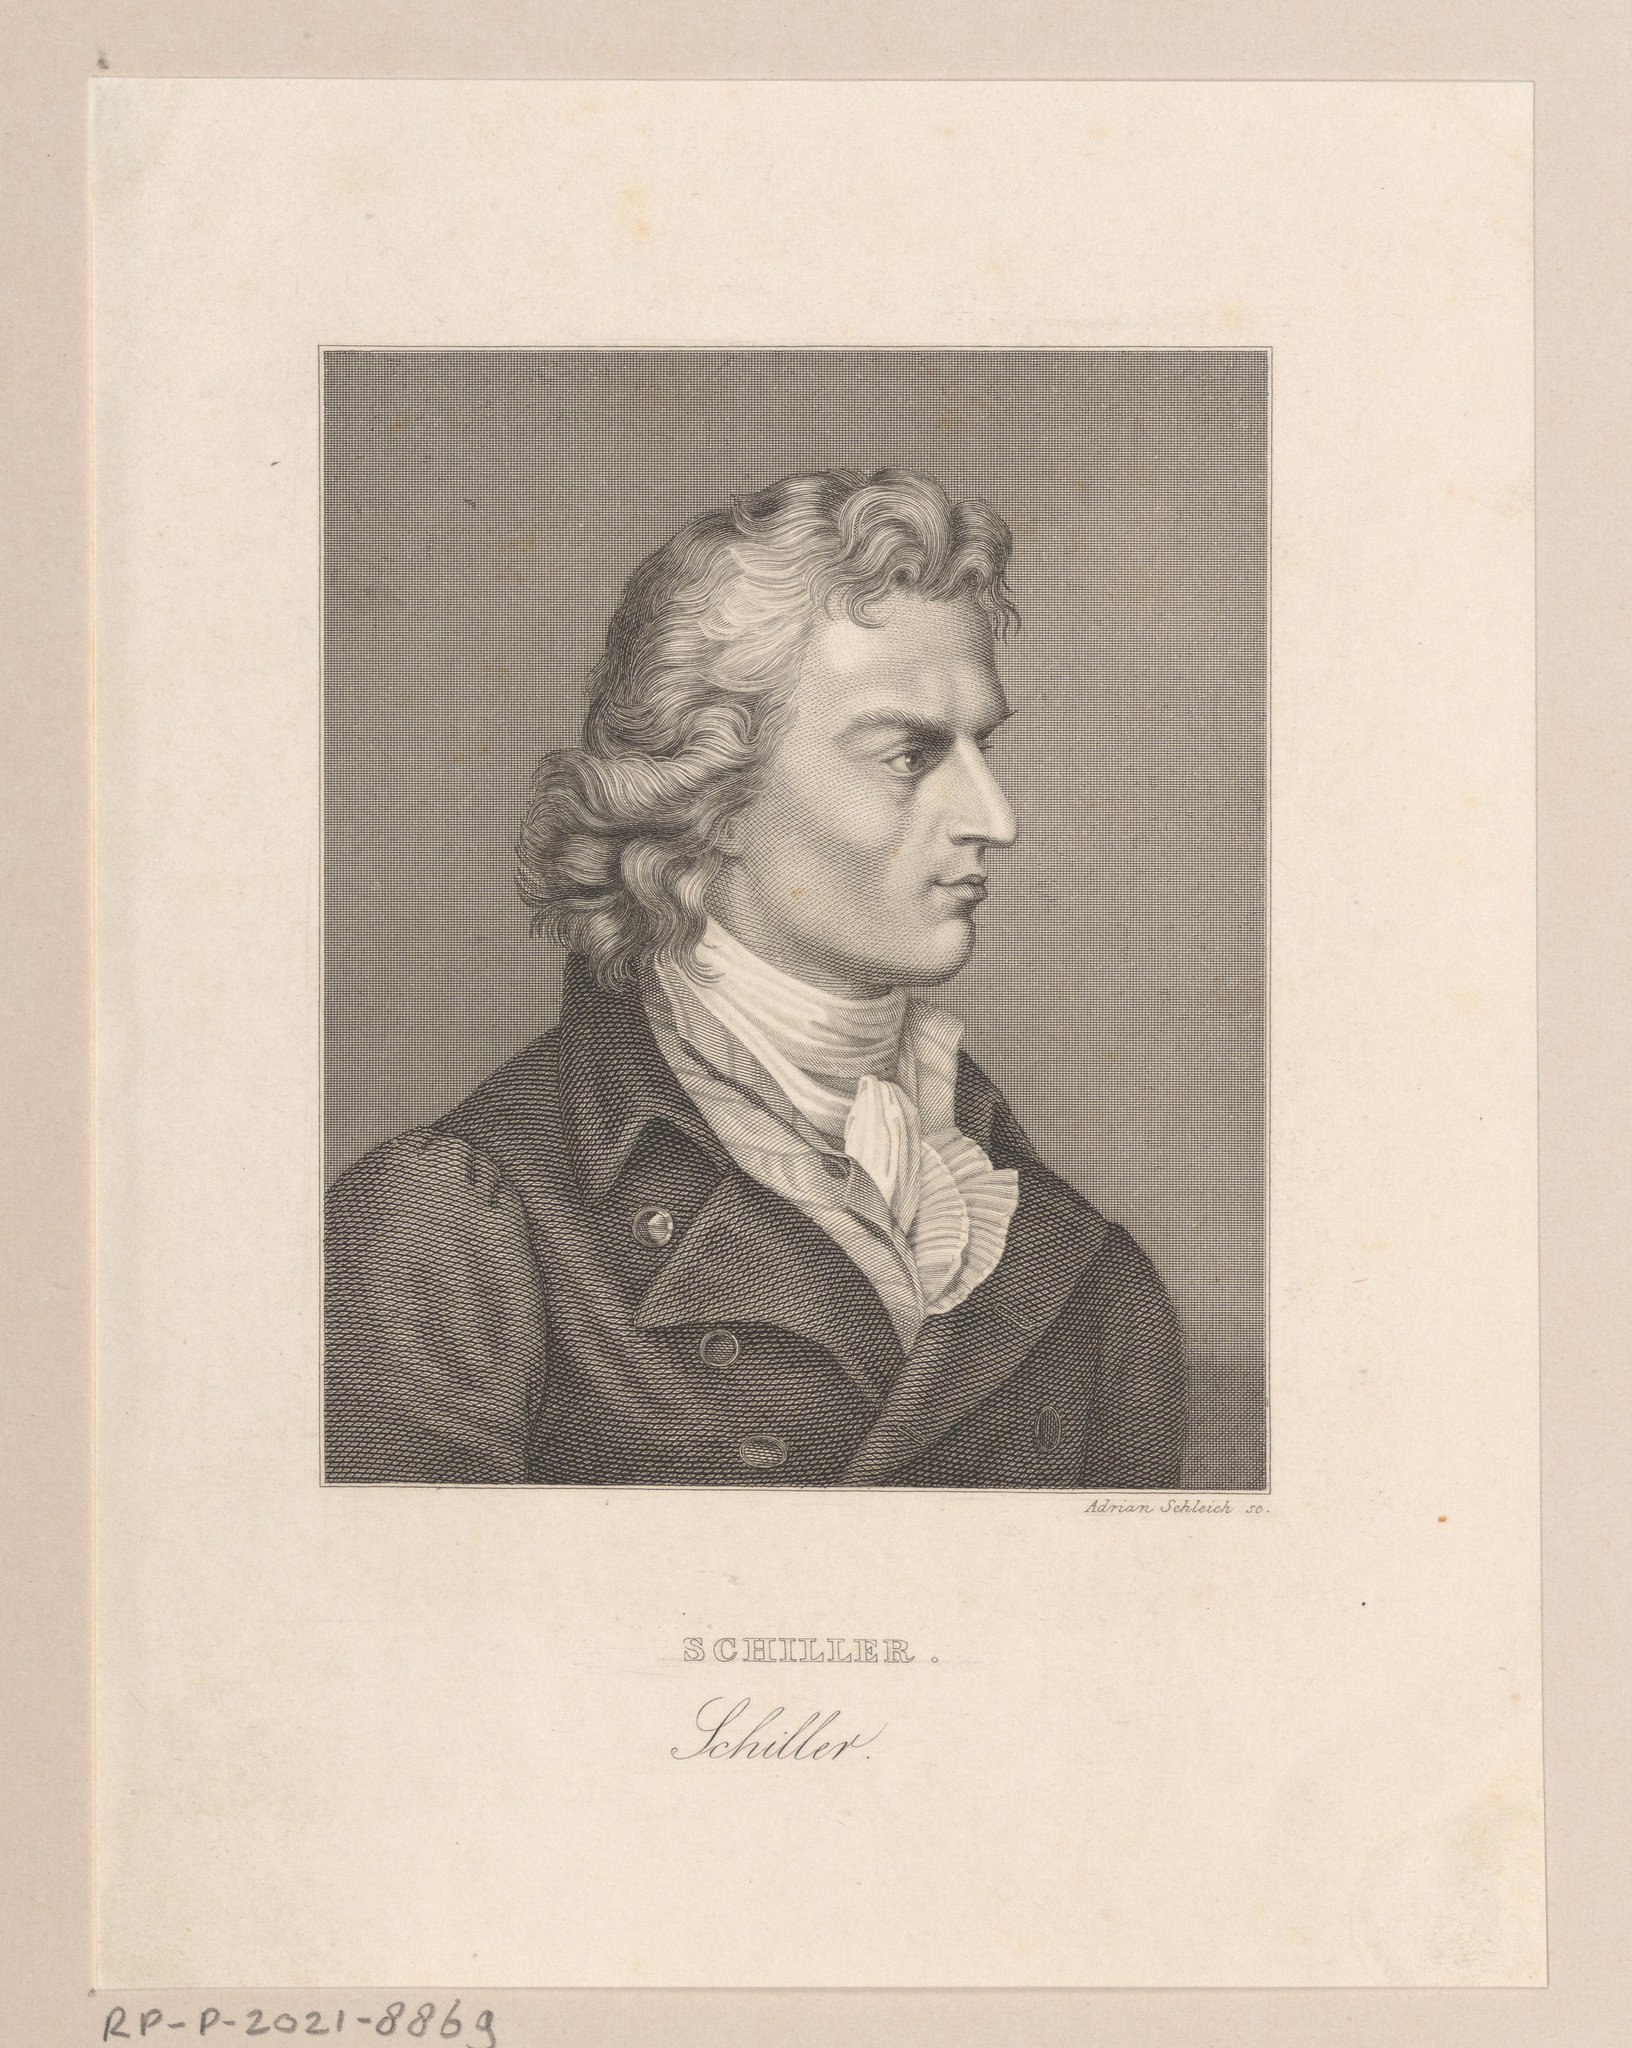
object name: print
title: Portret van Friedrich von Schiller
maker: adrian schleich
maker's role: print maker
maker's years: 1812-1894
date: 1822-1894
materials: paper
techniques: engraving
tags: friedrich von schiller, scholar, philosopher, historical persons, portrait of a writer